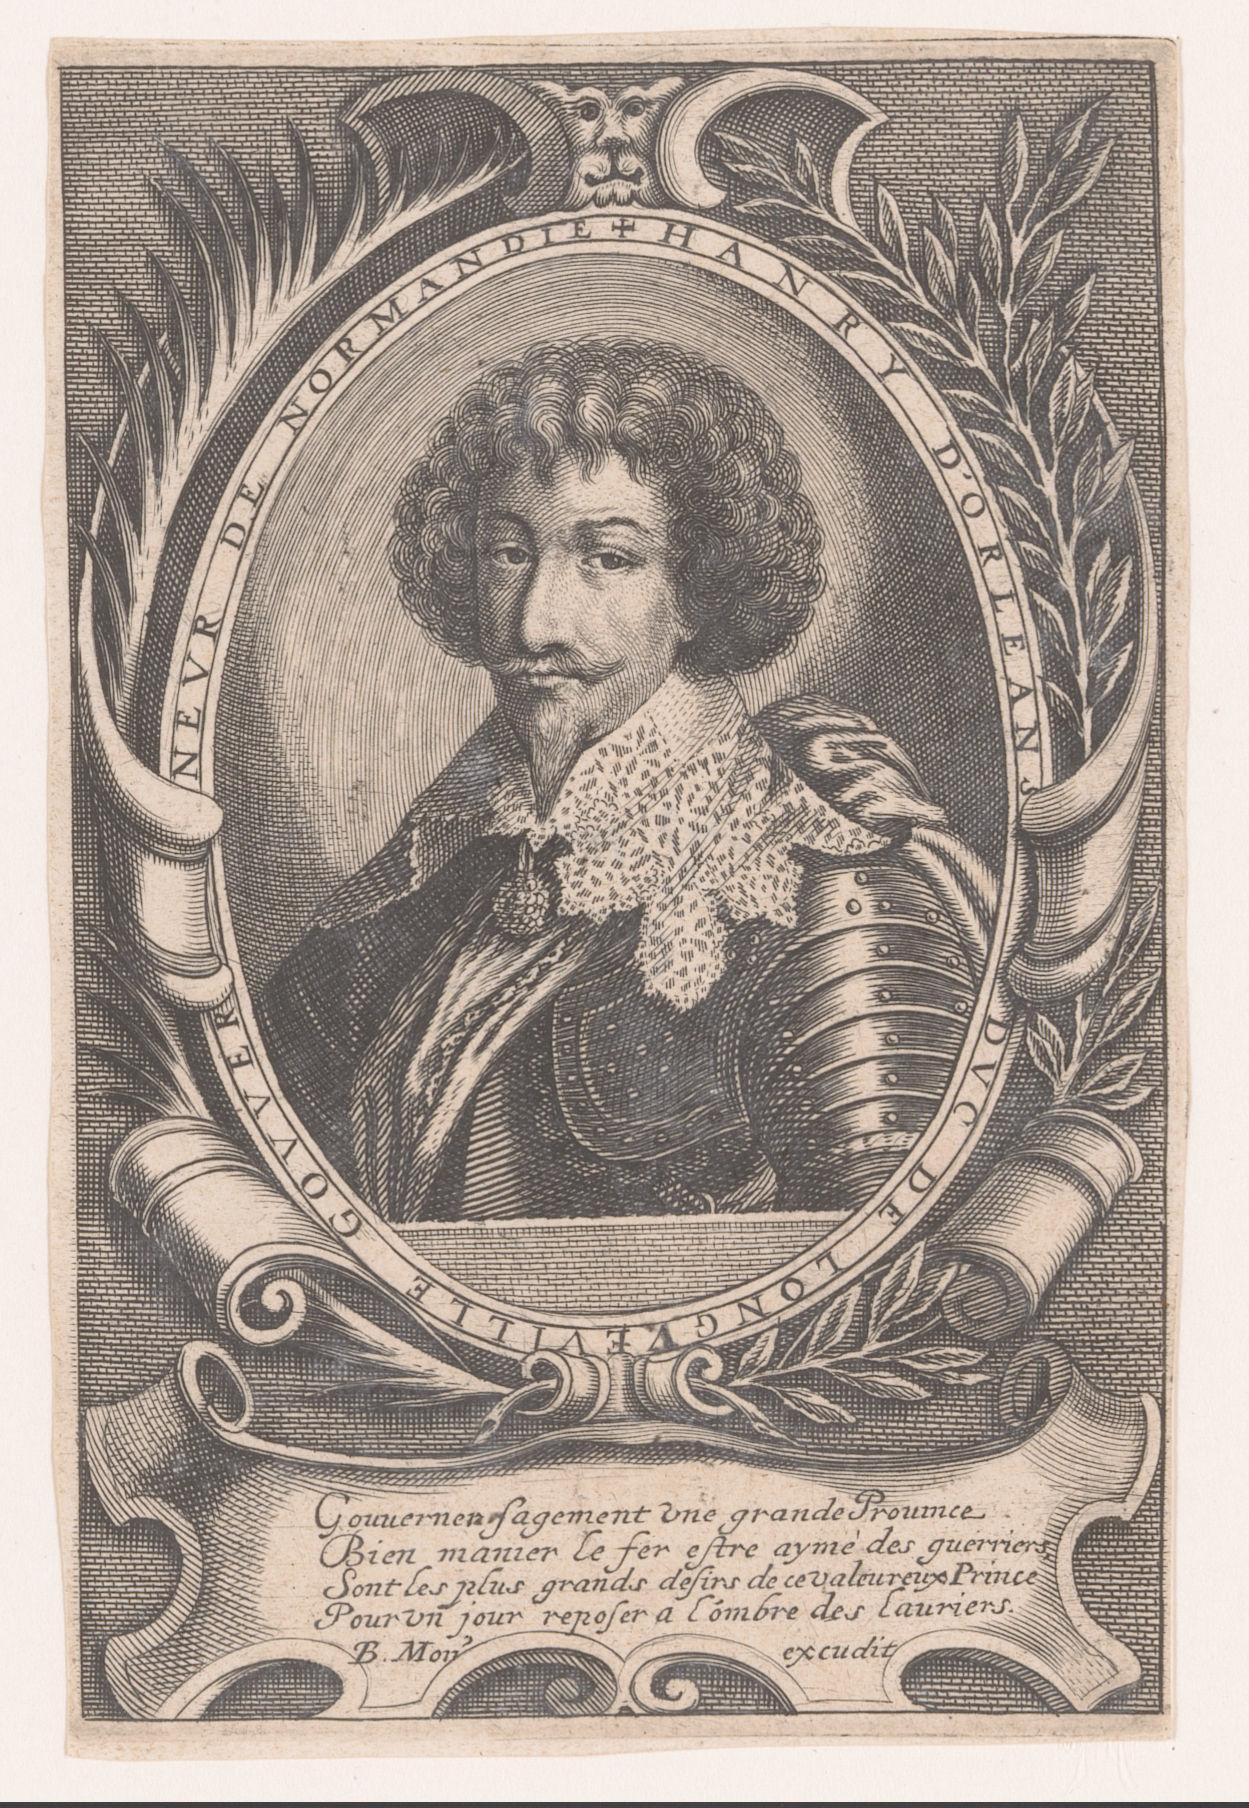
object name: print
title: Portret van Hendrik II van Longueville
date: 1620-1668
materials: paper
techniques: engraving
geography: paris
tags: historical persons, nobility and patriciate; chivalry, knighthood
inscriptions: collector's mark: Lugt 2228